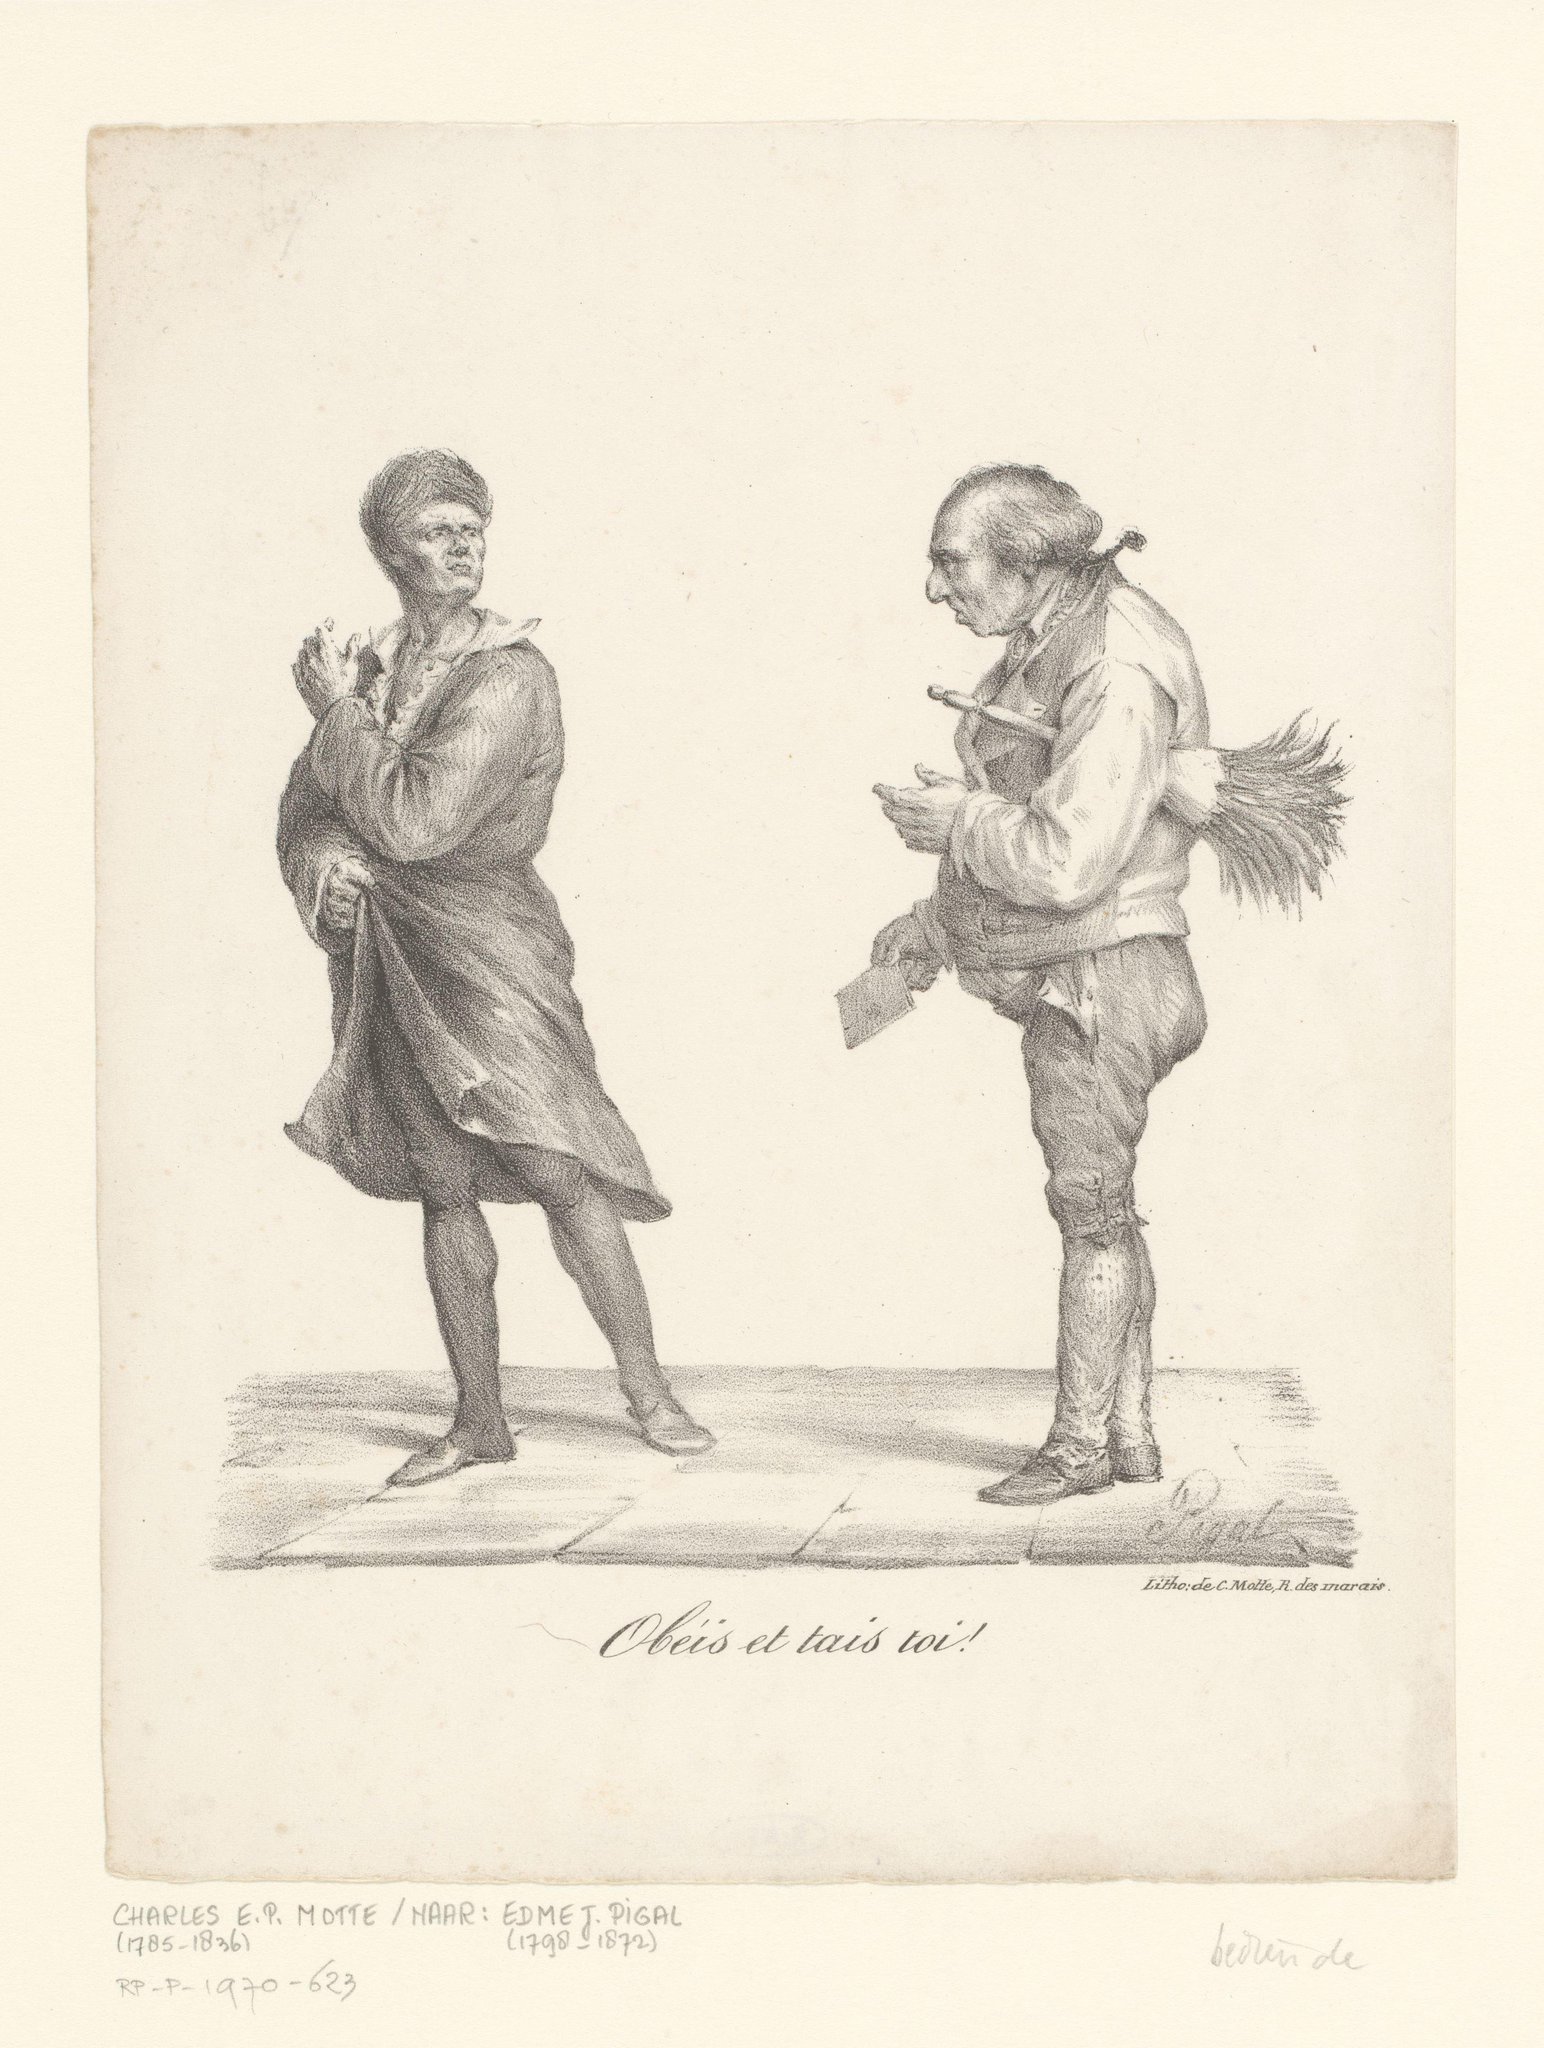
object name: print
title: Obéis et tais toi!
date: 1822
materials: paper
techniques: lithograph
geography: paris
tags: adult man ( + one person)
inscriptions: collector's mark: Lugt 2228